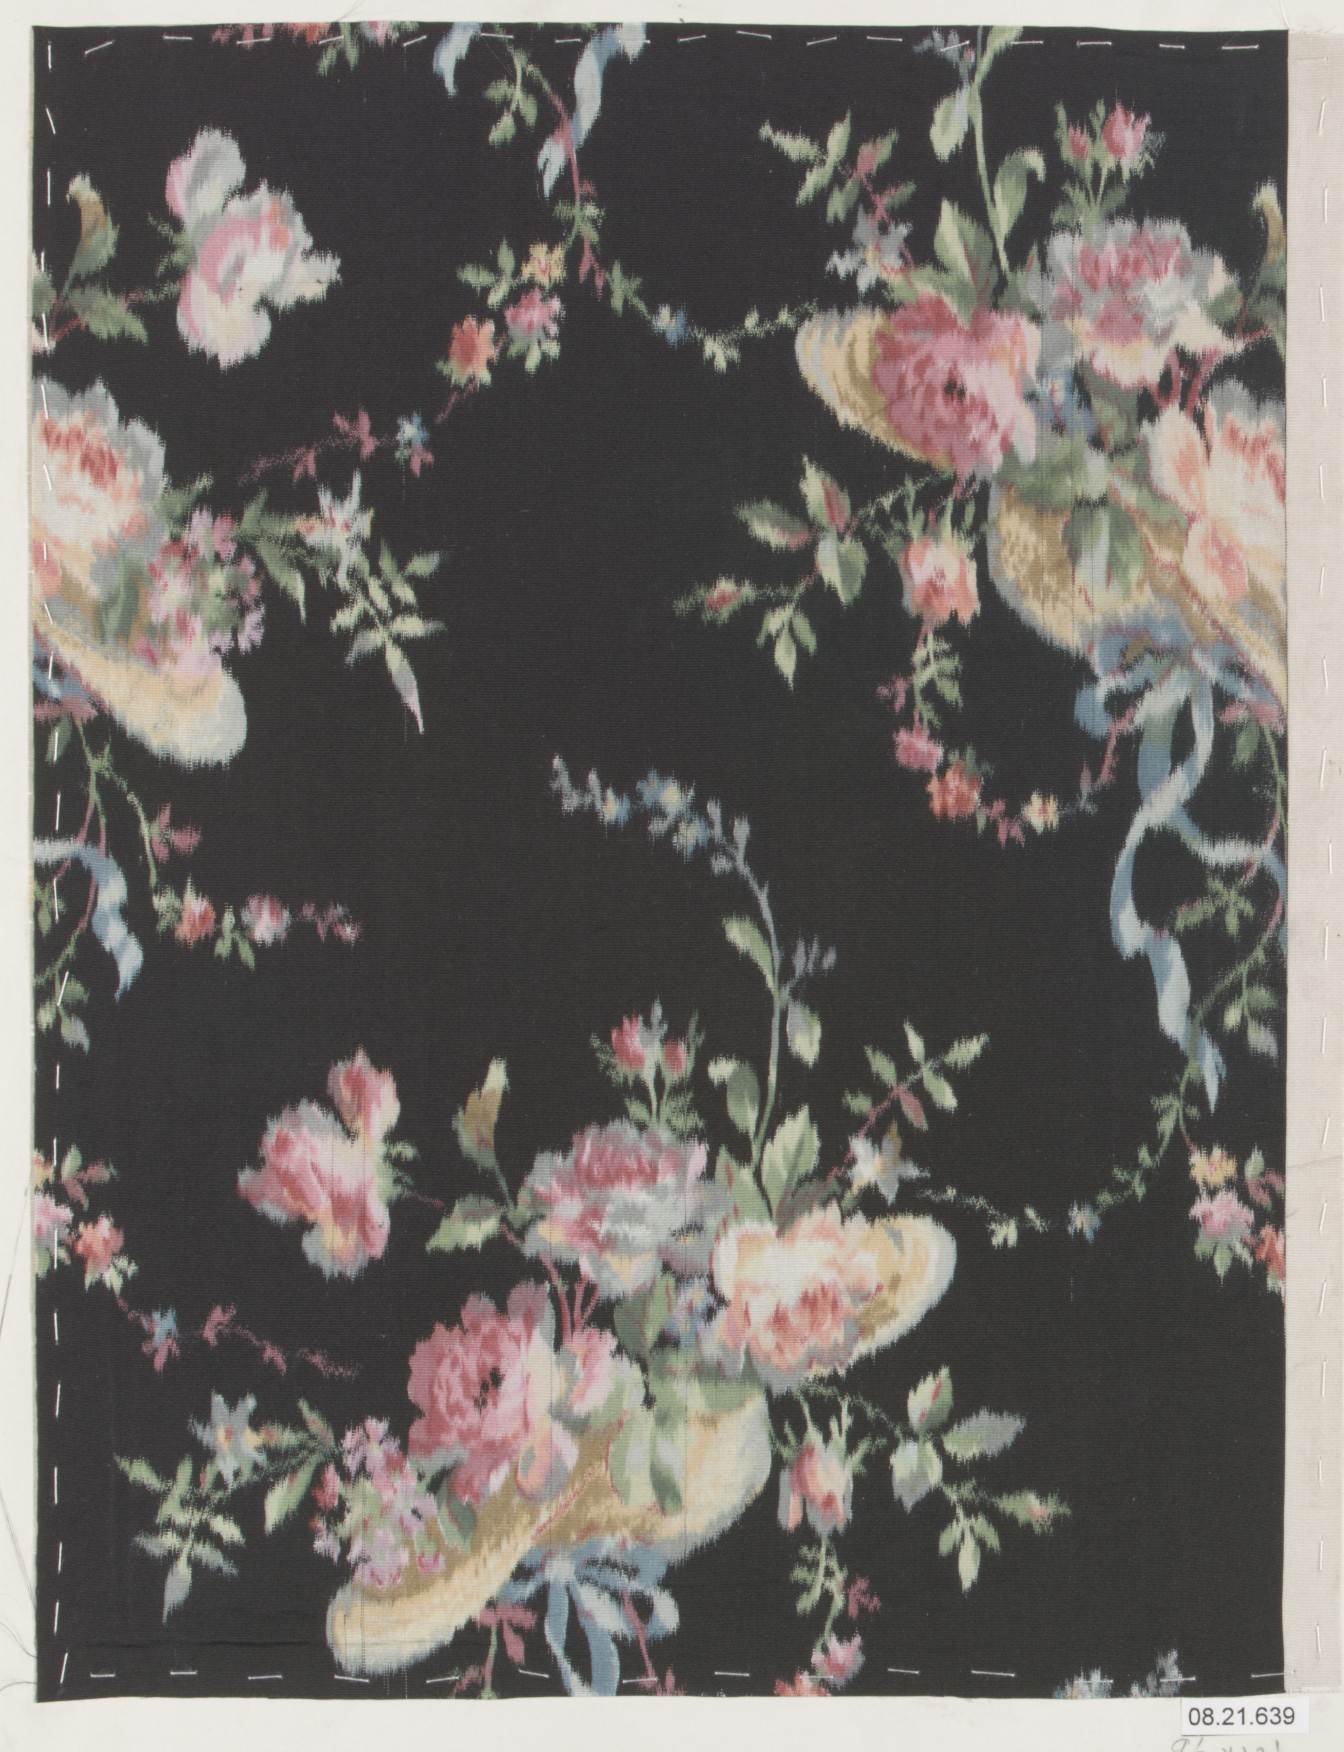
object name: textile sample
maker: Anonymous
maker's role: designer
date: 1900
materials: silk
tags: roses